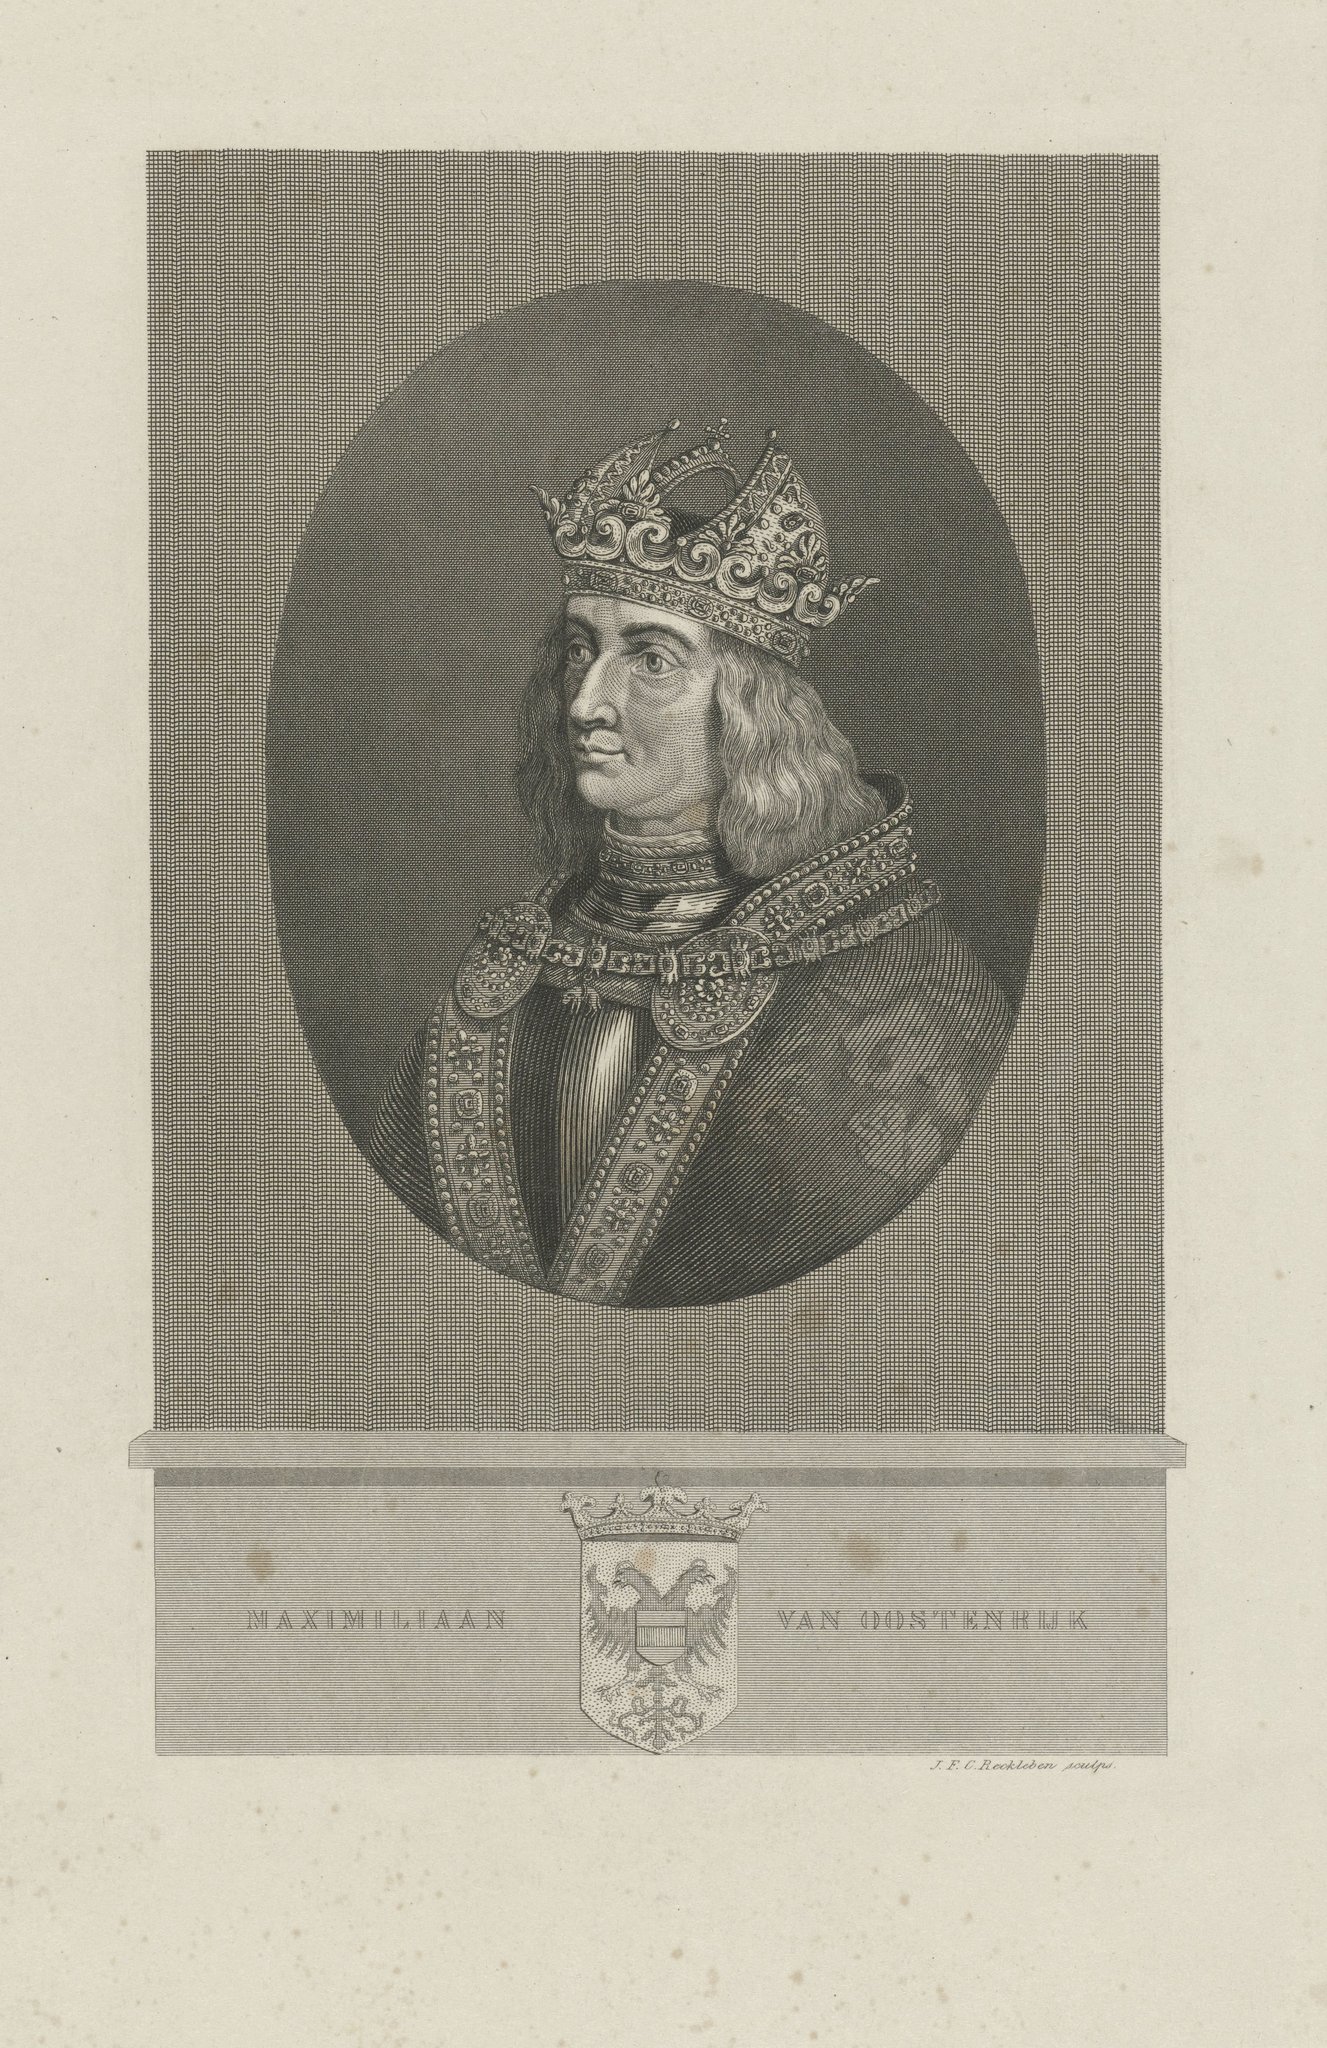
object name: print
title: Portret van keizer Maximiliaan I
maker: jan frederik christiaan reckleben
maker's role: print maker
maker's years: 1819-1879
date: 1847-1849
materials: paper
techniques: engraving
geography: amsterdam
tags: maximilian i (holy roman emperor), knighthood order of the golden fleece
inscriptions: collector's mark: Lugt 2228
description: Illustratie in: Arend, Johannes Pieter. Algemeene geschiedenis des vaderlands van de vroegste tijden tot op heden. 5 delen, Amsterdam: Schleijer, J.F. 1840-1884, dl 2.3, p. 298.